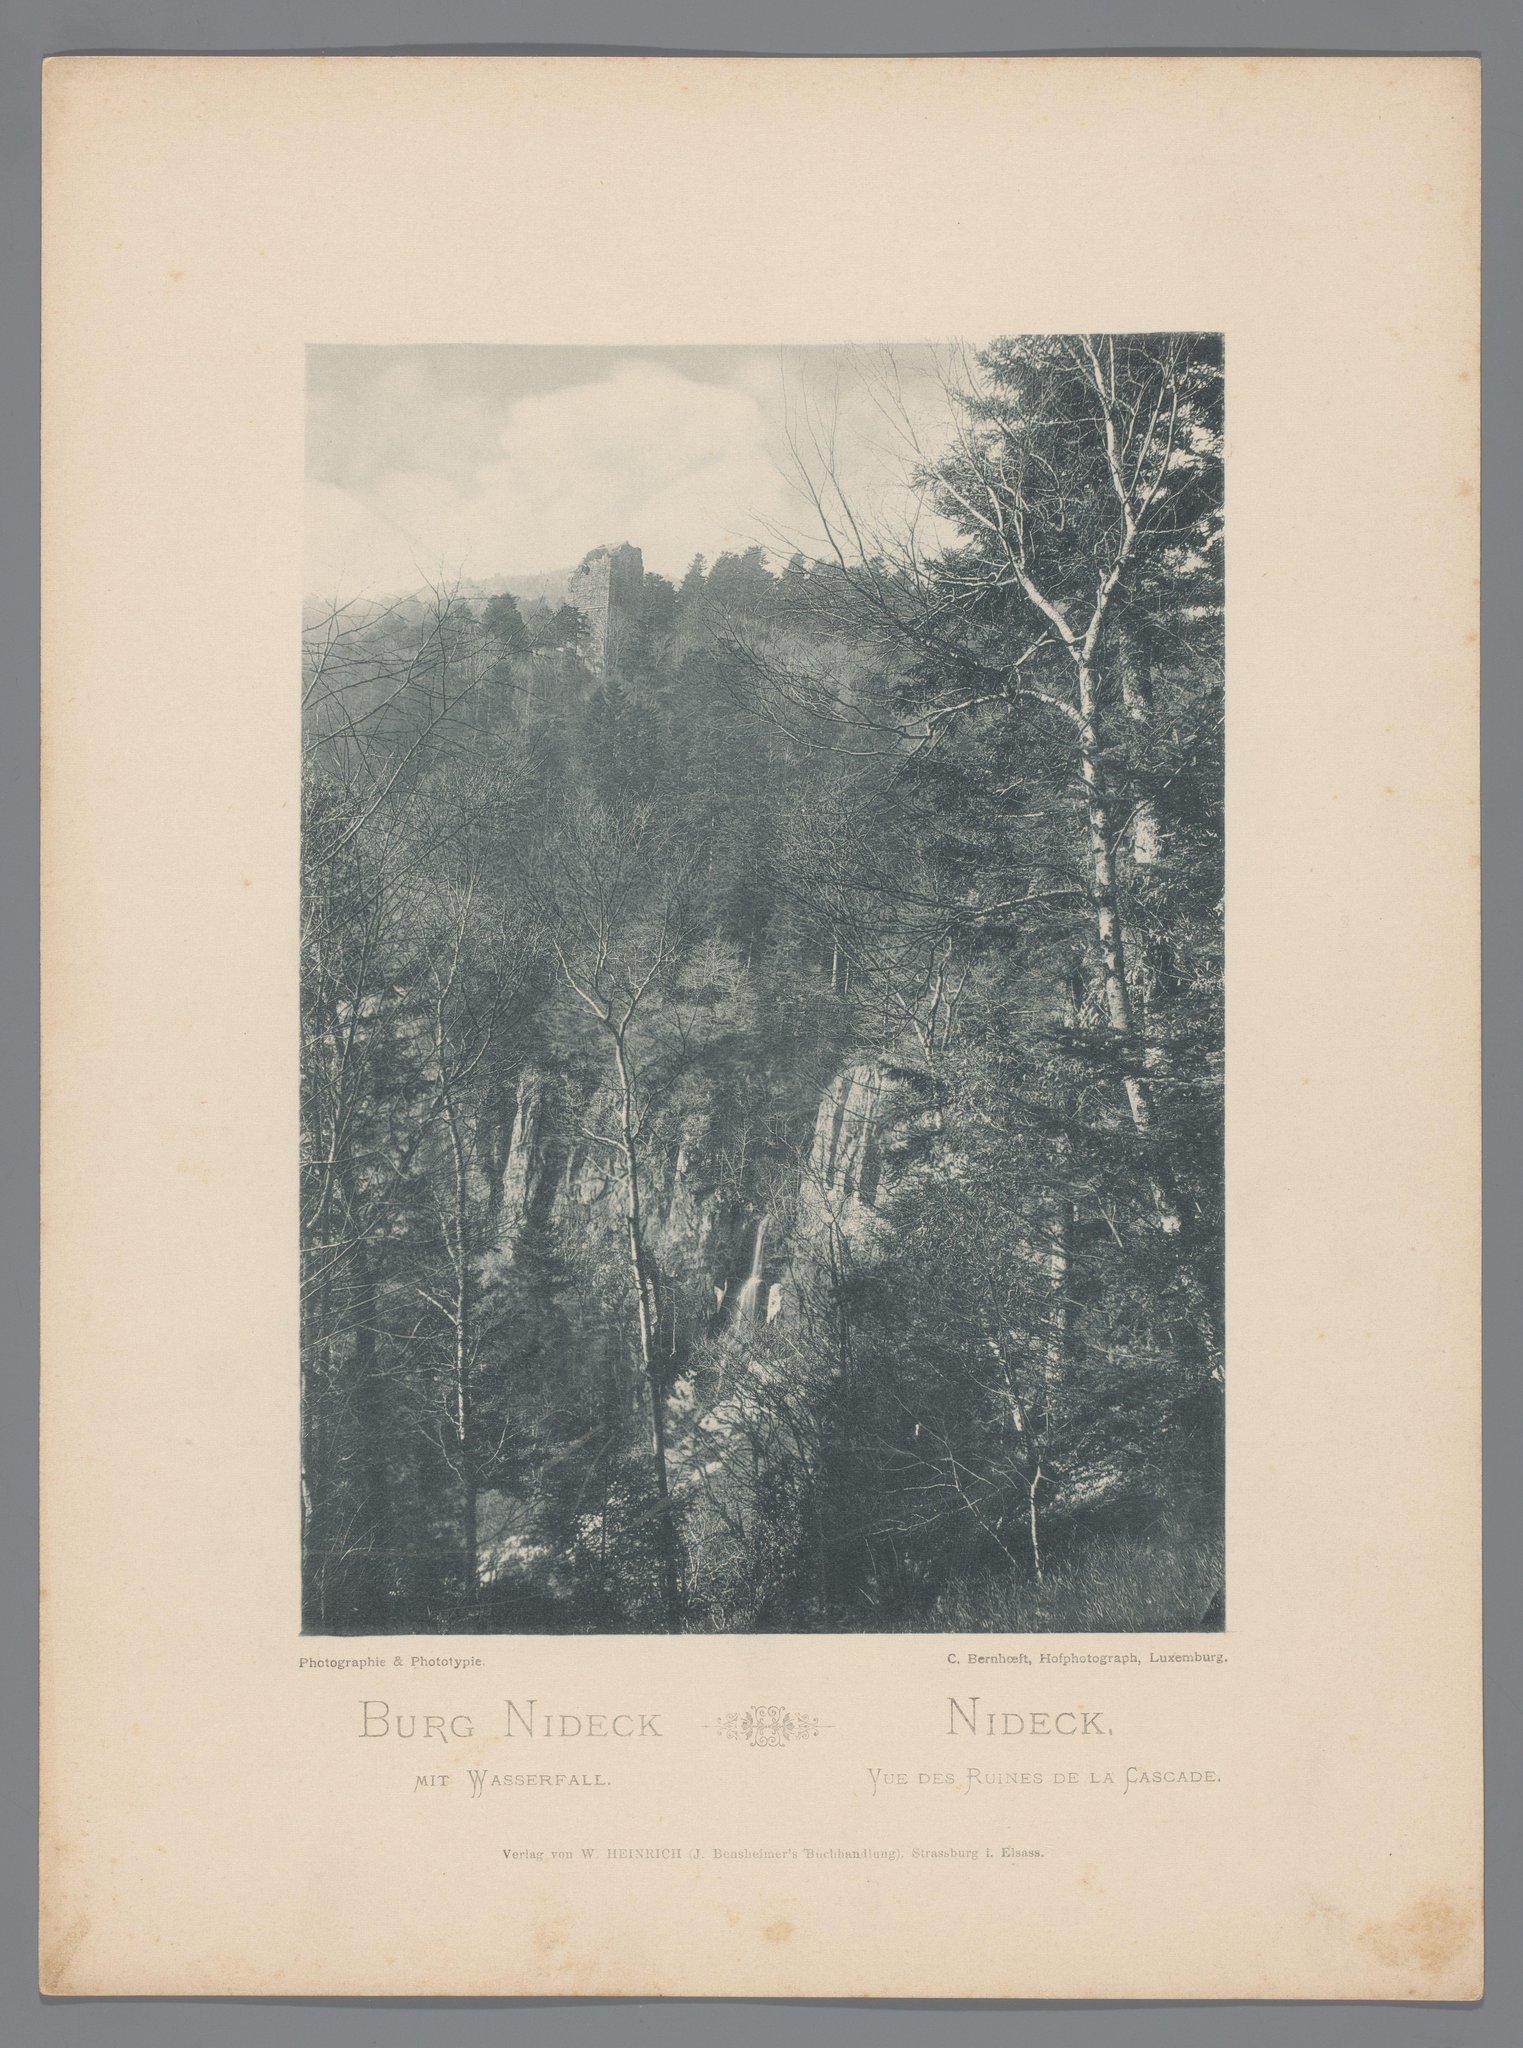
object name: page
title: Burg Nideck, Nideck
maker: charles bernhoeft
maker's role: publisher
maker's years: 1859-1933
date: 1889-1894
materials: paper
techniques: photograph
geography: straatsburg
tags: castle, waterfall, landscape with ruins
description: Deze prent maakt deel uit van een omslag met 100 prenten.